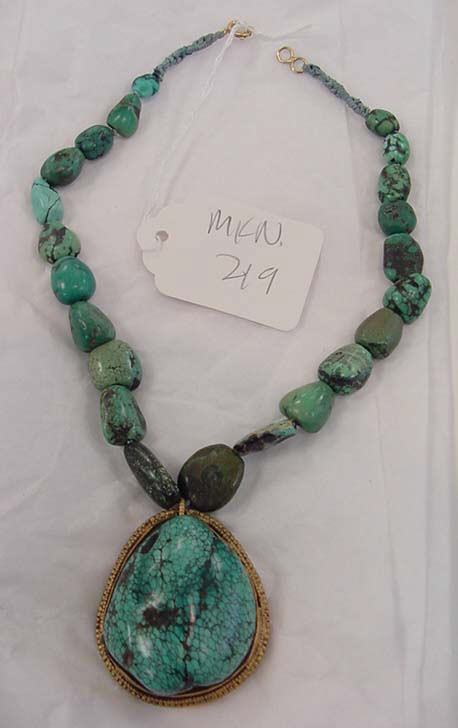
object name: necklace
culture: tibetan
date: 1801-1900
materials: cotton, metal